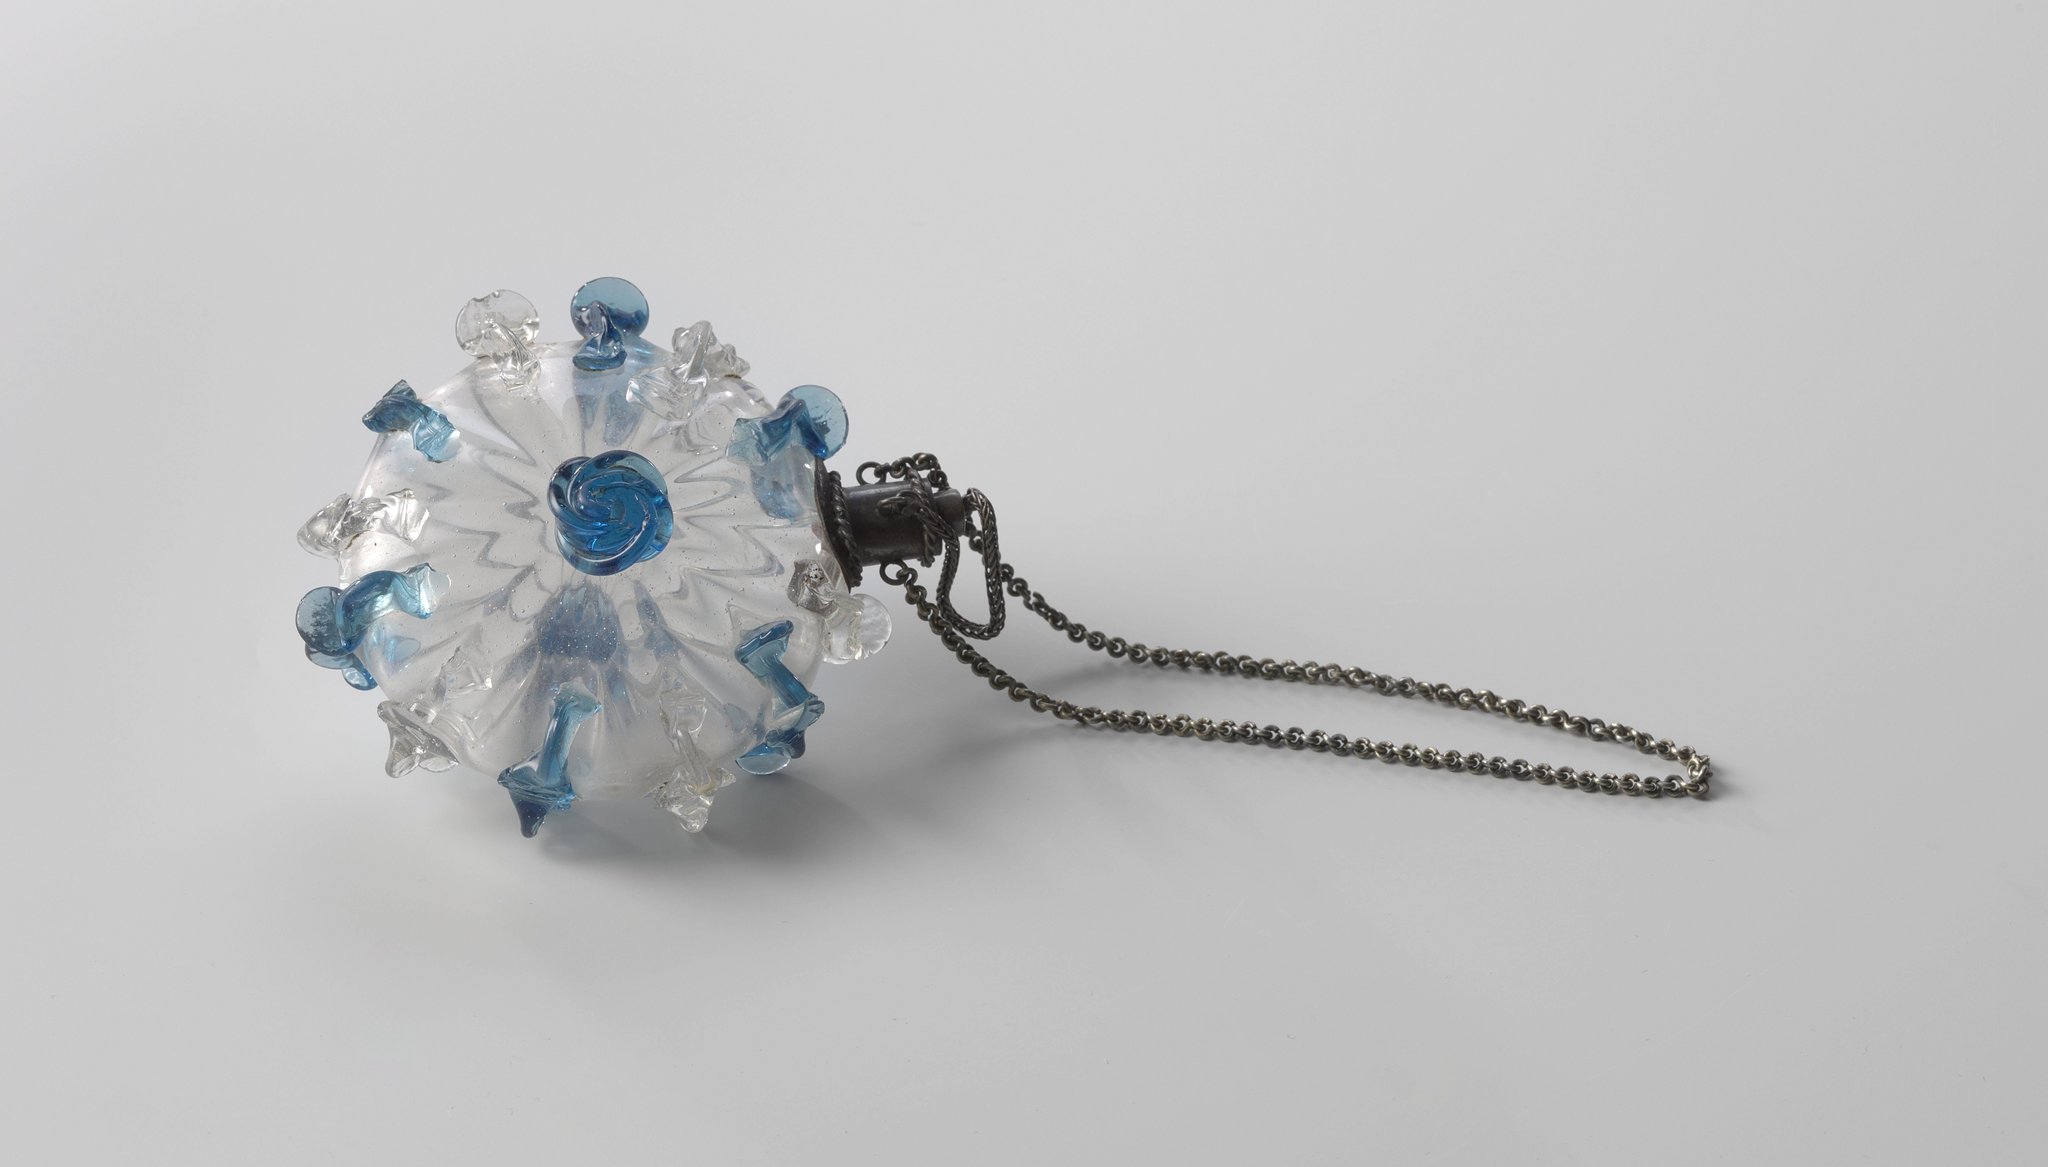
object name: flacon, flakon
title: Flacon met ketting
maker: Anonymous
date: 1600-1800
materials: glass, silver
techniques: façon de venise, glassblowing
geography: western europe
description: Flacon, rond en plat, in de vorm geblazen met straalsgewijze ribben. De mond gevat in een zilveren montuur met een stop aan een gevlochten ketting, en een schakelketting om de fles aan een ceintuur te hangen. Aan beide zijden centraal een getordeerd blauwe nop , de rand afgezet met kleine blauwe en kleurloze geknepen ornamenten.